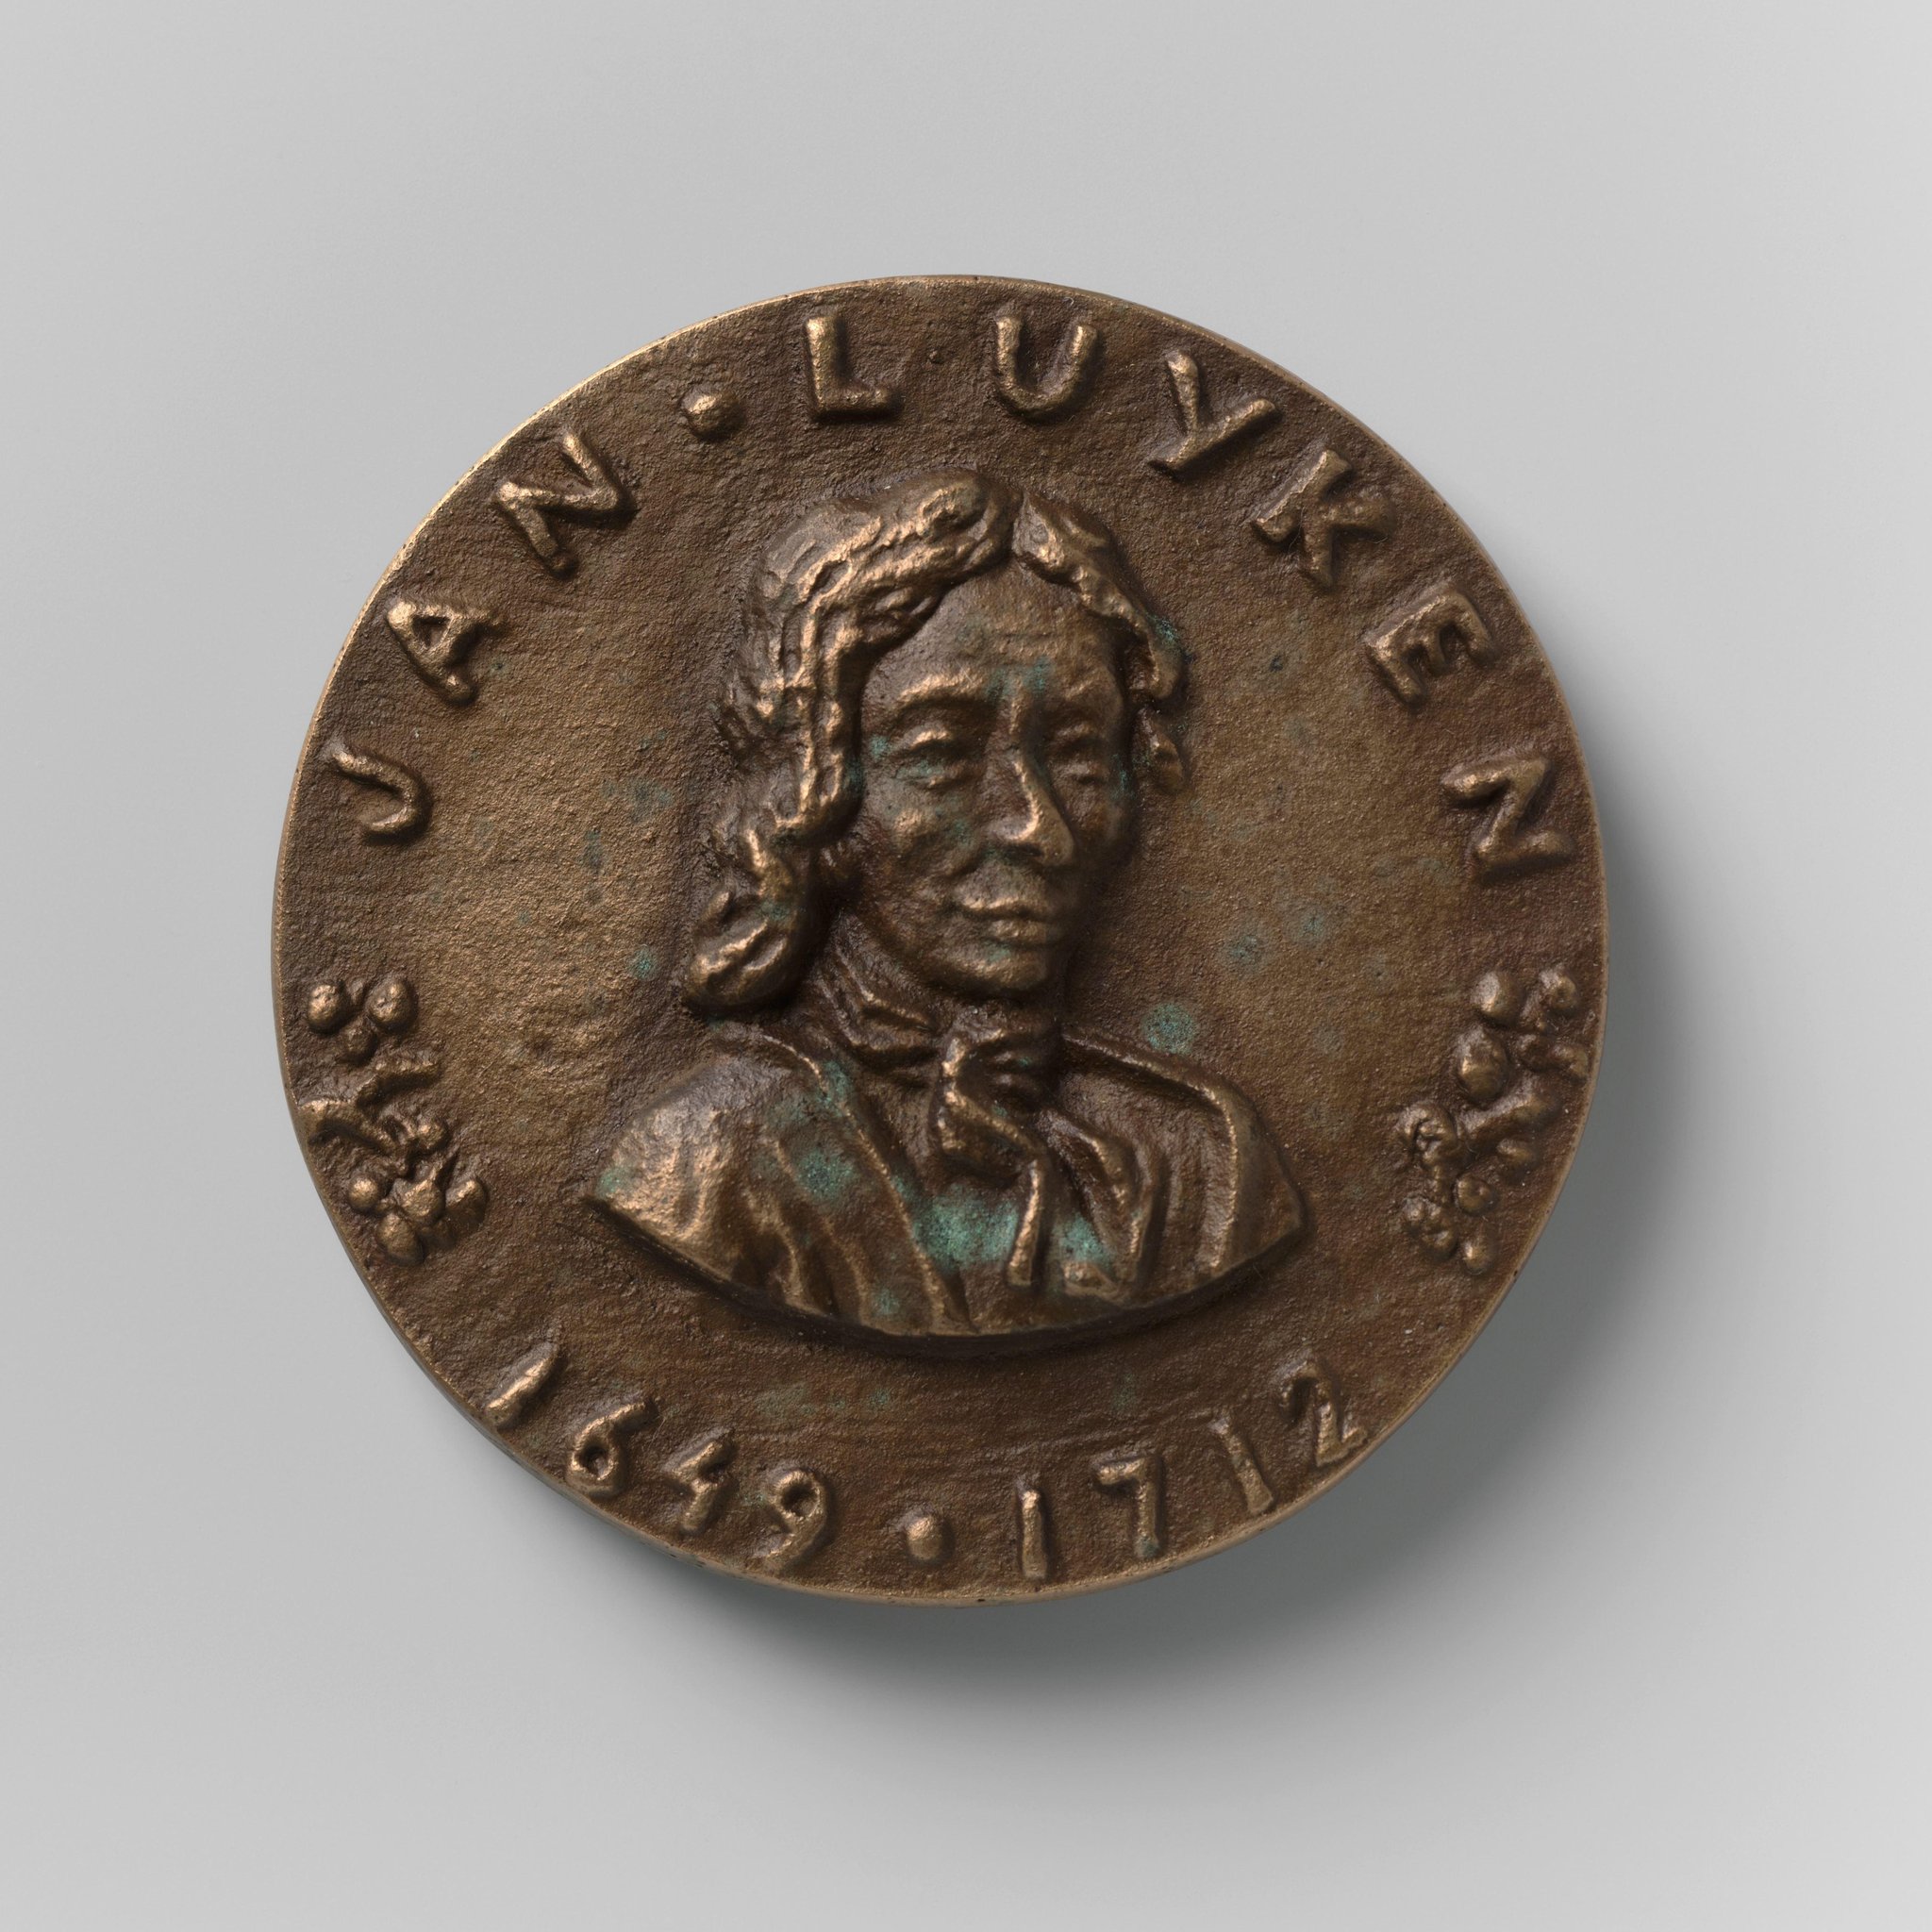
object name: history medal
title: Driehonderdste geboortejaar van Jan Luyken (Vereniging voor Penningkunst 1949, eerste penning)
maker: bram roth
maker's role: sculptor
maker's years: 1916-1995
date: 1949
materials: bronze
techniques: casting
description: Bronzen penning, op de voorzijde het borstbeeld van Luyken half naar rechts met omschrift, op de keerzijde Luyken aan het werk in zijn atelier, met omschrift, met verklaring.